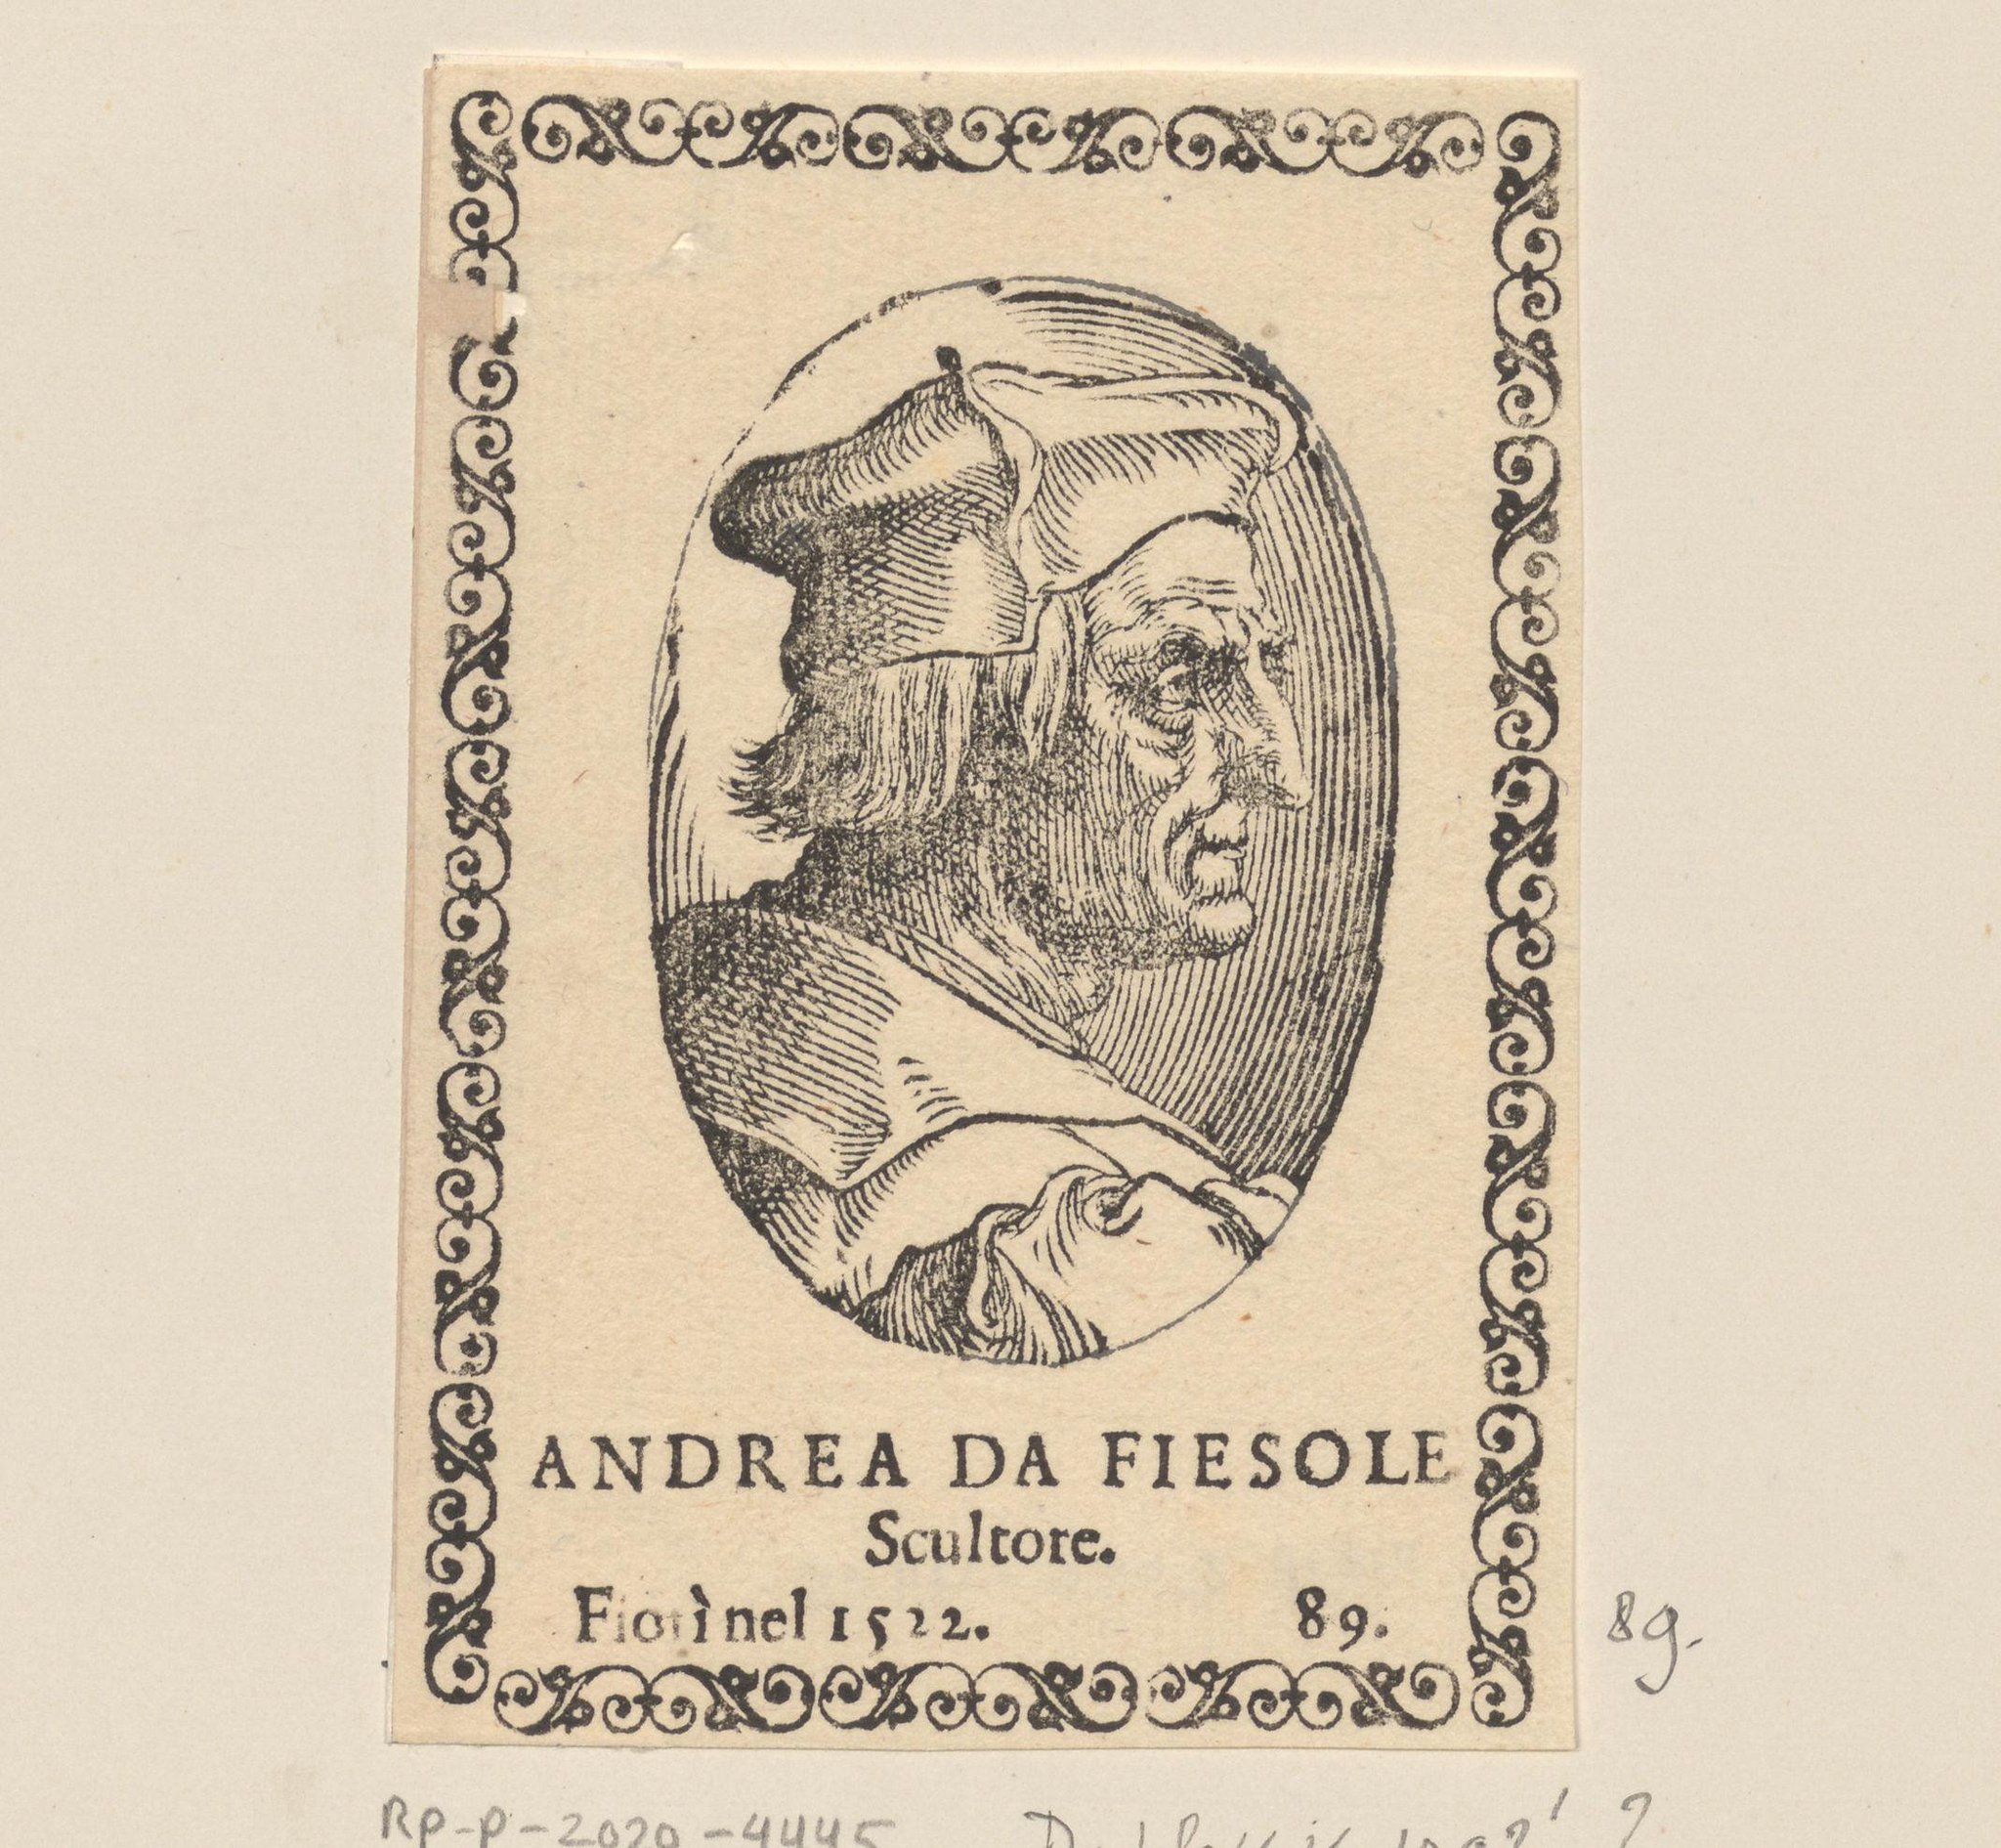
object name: print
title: Portret van Andrea Ferrucci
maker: cristoforo coriolano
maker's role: print maker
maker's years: 1540-1610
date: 1568-1650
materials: paper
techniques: letterpress printing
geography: italy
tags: sculptor, andrea ferrucci, portrait, self-portrait of sculptor, historical persons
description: Prent komt uit een editie van Vasari's 'Vite'. Prent met een andere omlijsting is gebruikt in de editie uit 1568: Vasari, Giorgio. Le vite de' piu eccellenti pittori scultori, e architettori. Florence: Filippo Giunta, 1568. Vergelijkbare prenten zijn ook gebruikt in de editie uit 1647.